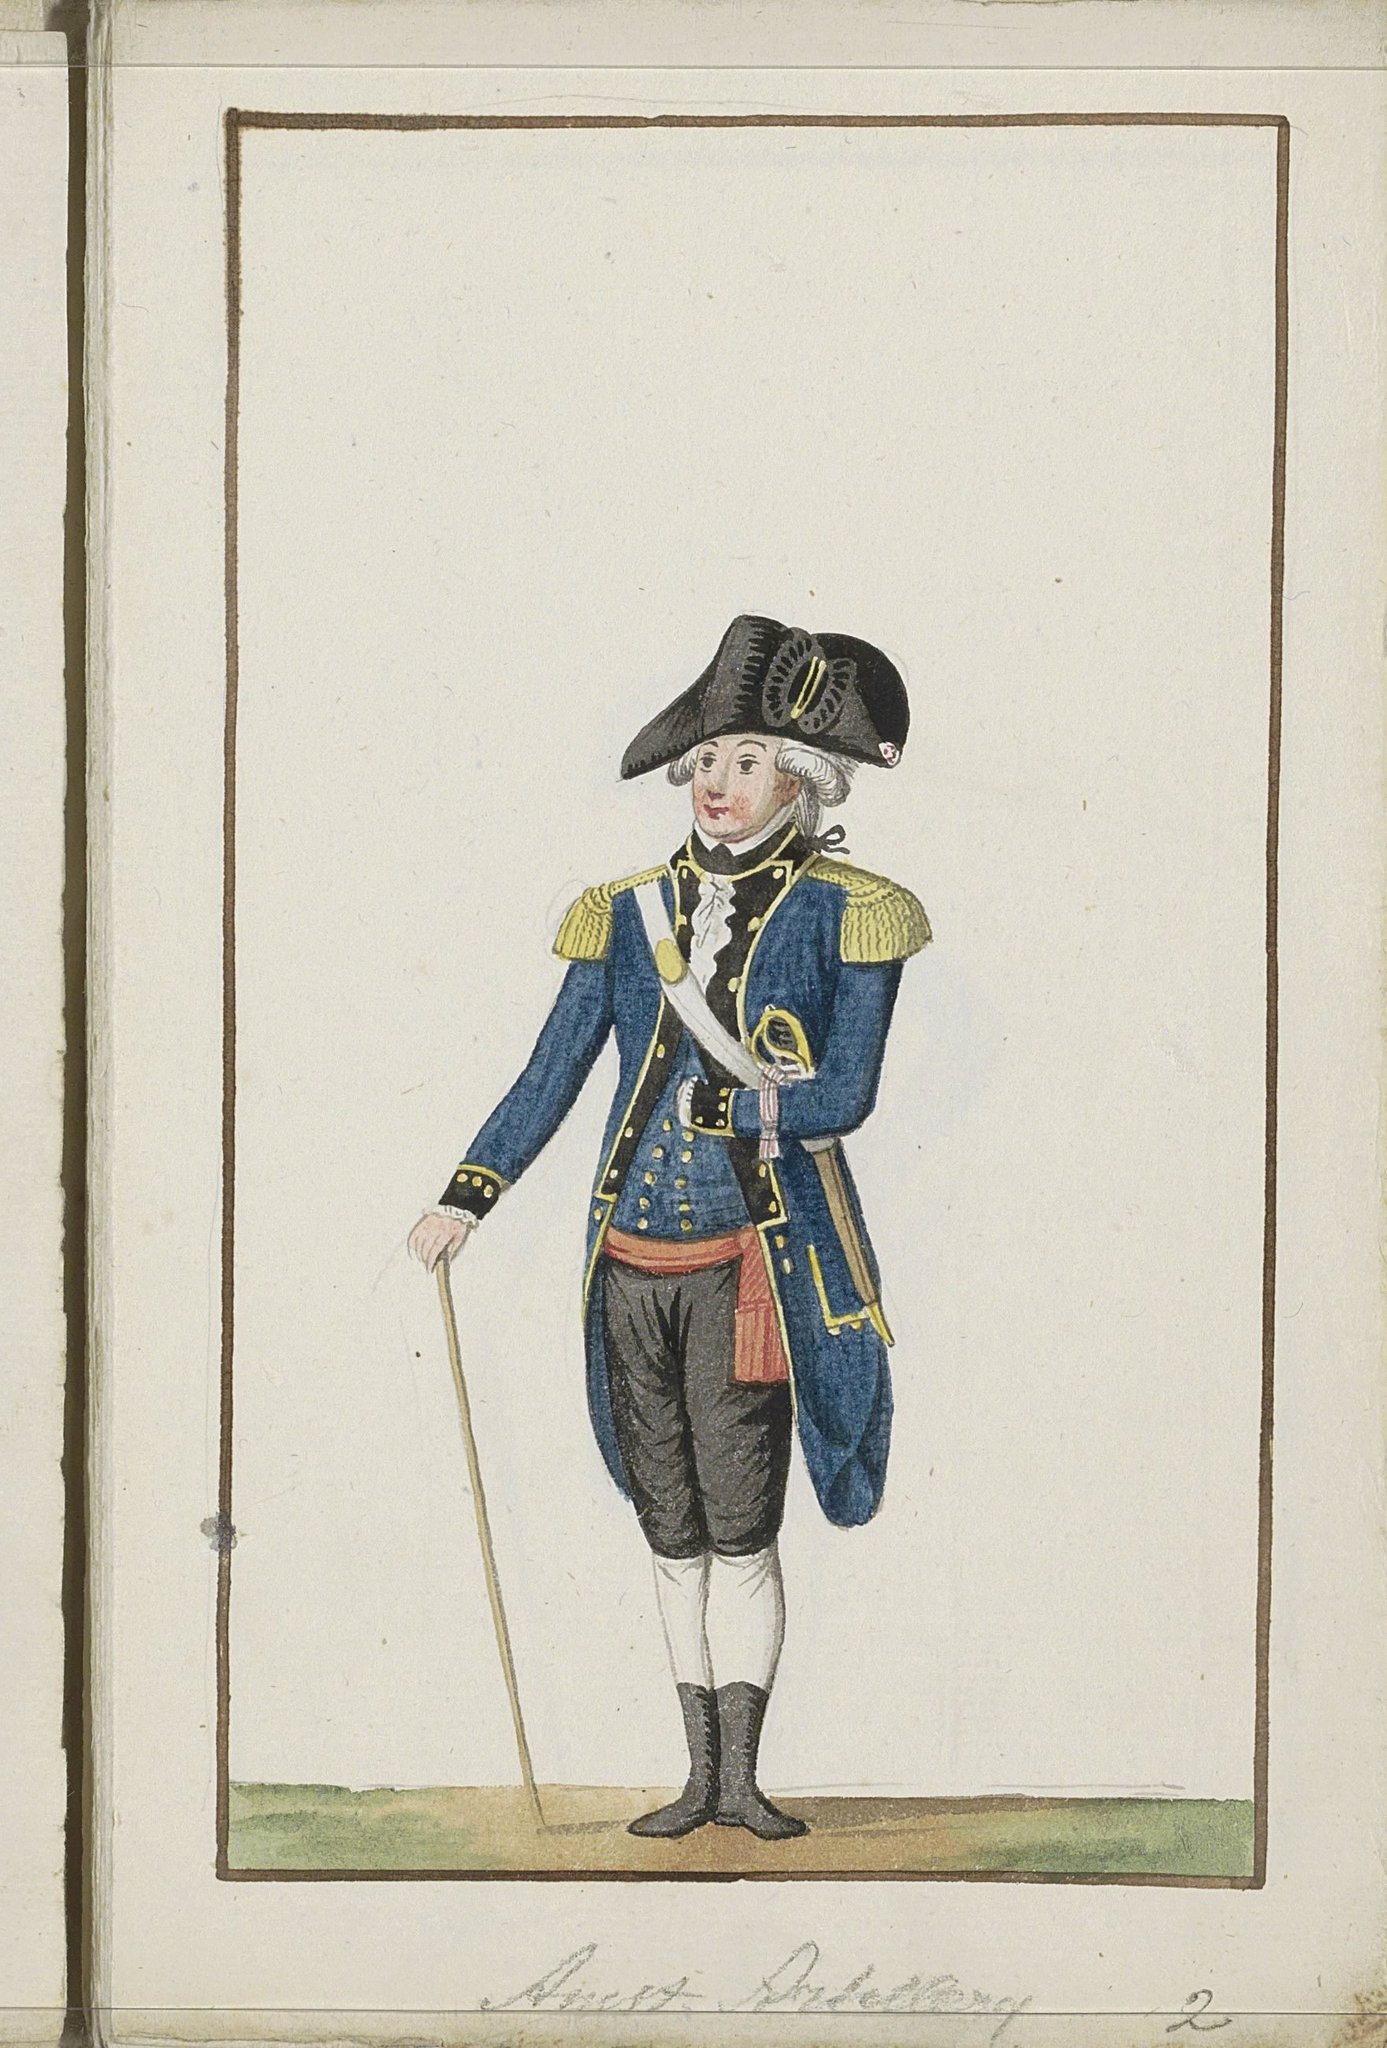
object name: costume print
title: Amsterdam Atlary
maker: Anonymous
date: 1789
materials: paper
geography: northern netherlands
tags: (military) uniforms (+ citizen soldiery, civil guard, citizen militia), amsterdam, patriots (1780-1795)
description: Montering of uniform van de artillerie van Amsterdam, ca. 1785. Onderdeel van een schetsboek met 41 gekleurde tekeningen van de monteringen van de gewapende schutterijen en burgercorpsen in Nederland in de periode ca. 1783-1789.